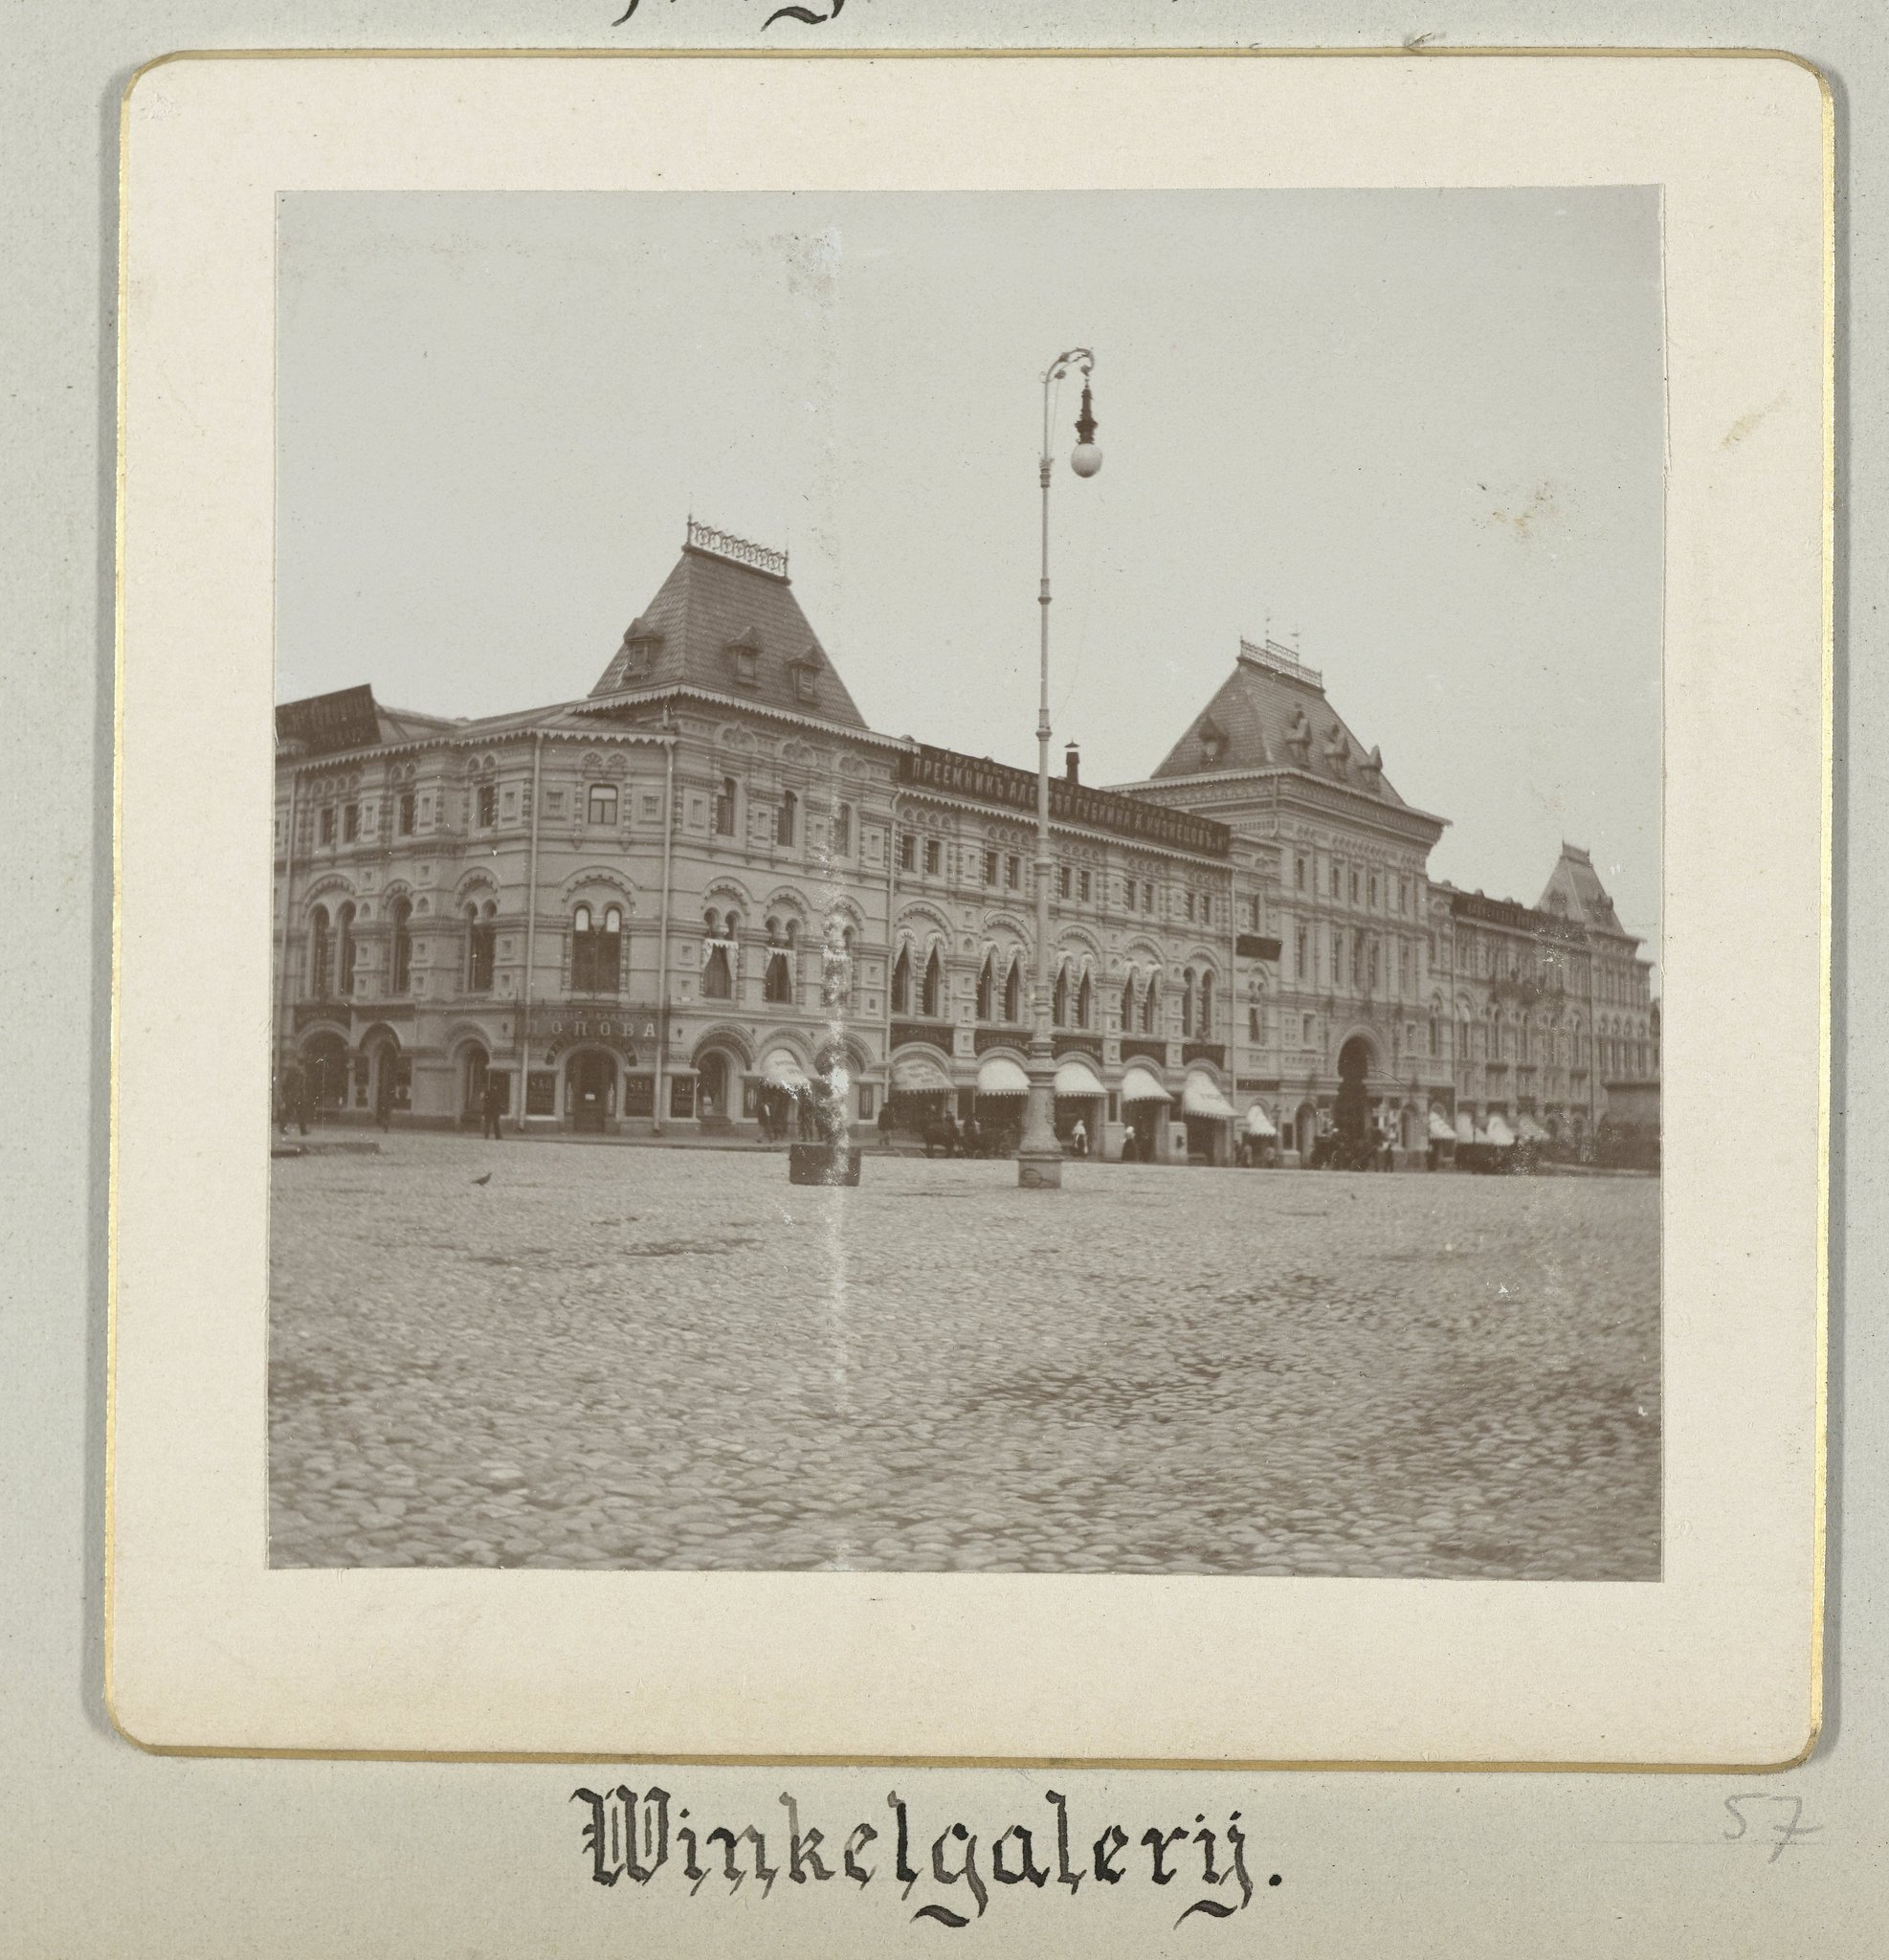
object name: photograph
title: Vassili Cathedraal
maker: henry pauw van wieldrecht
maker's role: fotograaf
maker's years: 1863-1912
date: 1898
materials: paper, photographic support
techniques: albumen print